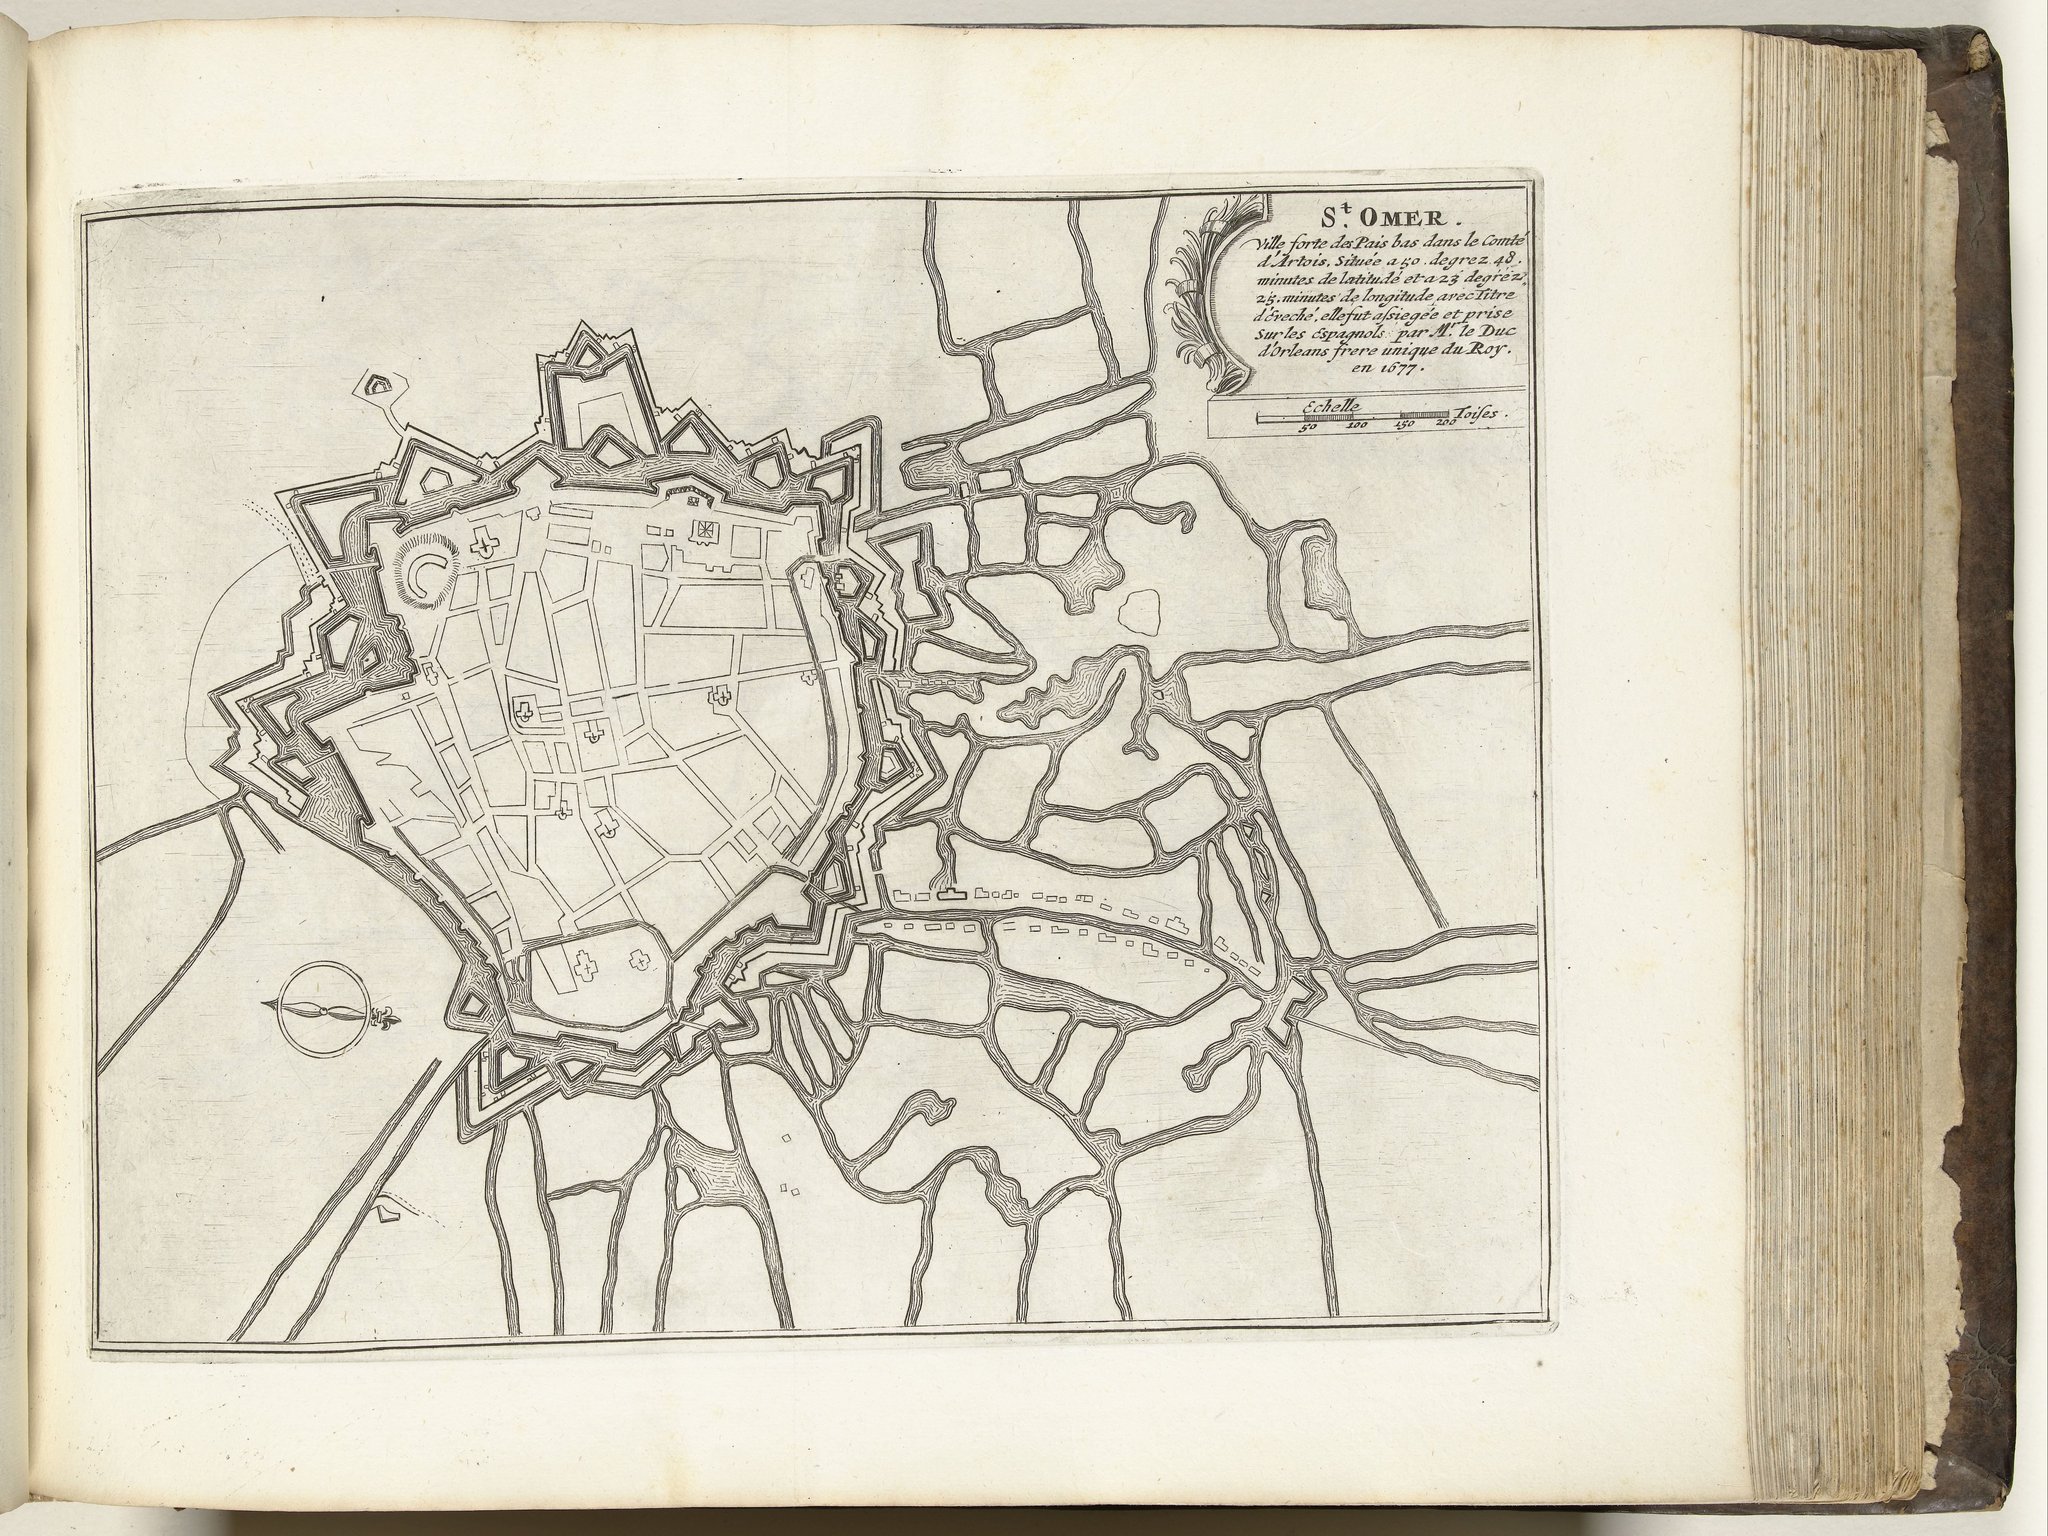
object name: print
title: St. Omer. Ville forte des Pais bas dans le Comté d'Artois (...)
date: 1693-1696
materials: paper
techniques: etching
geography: france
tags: fortress, maps of cities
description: Plattegrond van de versterkingen om de stad Saint-Omer in Artois. Onderdeel van het zesde deel (1696) van het prentwerk waarin gebundeld zijn de acht delen van Les forces de l'Europe uitgegeven tussen 1693-1697. Het prentwerk bestaat uit 175 platen met plannen (afkomstig van Sébastien Le Prestre, Seigneur de Vauban) van vermaarde sterke steden en vestingen in de Negenjarige Oorlog. Titel en opschriften in het Frans.